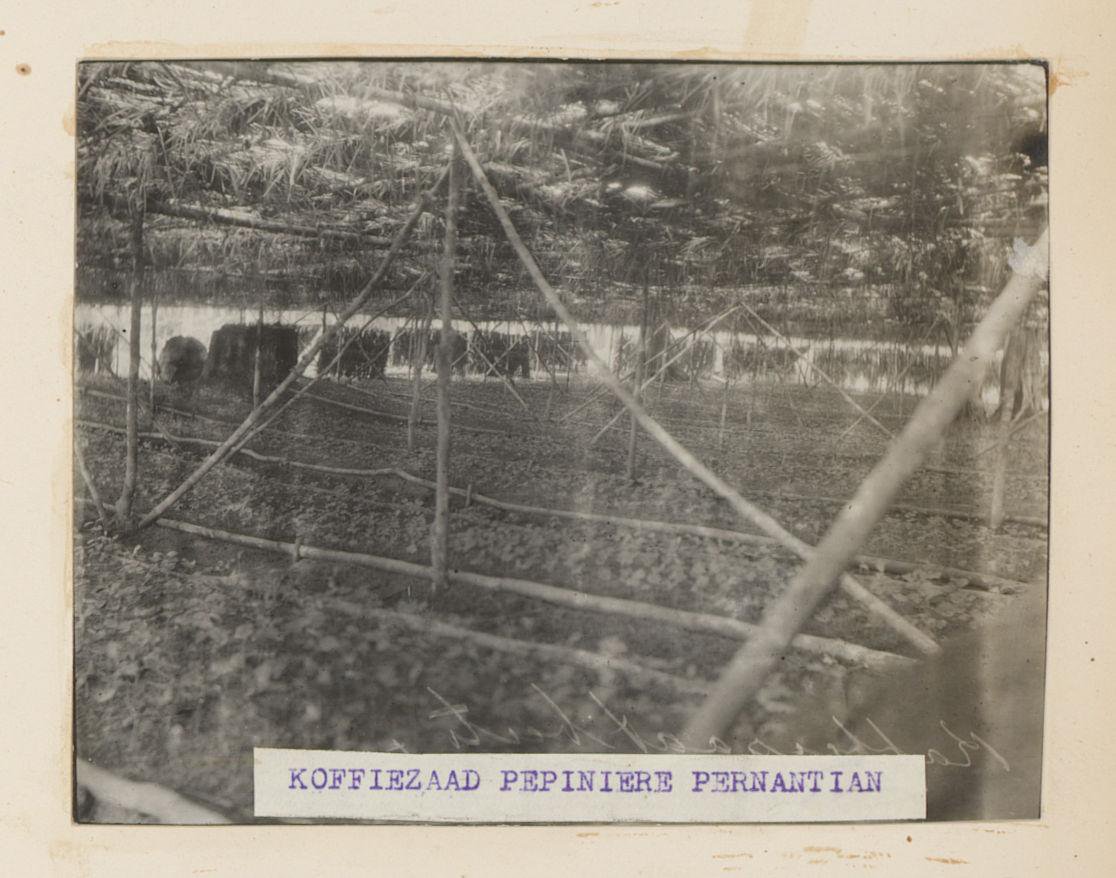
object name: photograph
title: Koffiezaad Pepiniere Pernantian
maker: Anonymous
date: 1910-1913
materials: photographic support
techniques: gelatin silver print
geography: east sumatra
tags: plantation, fruits: coffee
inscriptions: inscription: ‘Koffiezaad Pepiniere Pernantian’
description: Kwekerij met jonge koffieplanten op de plantage Pernantian. Met etiket onder de foto. Onderdeel van het fotoalbum over de plantages Brussel en Pernantian van de Sumatra Caoutchouc Maatschappij op de Oostkust van Sumatra in de jaren 1910-1935.